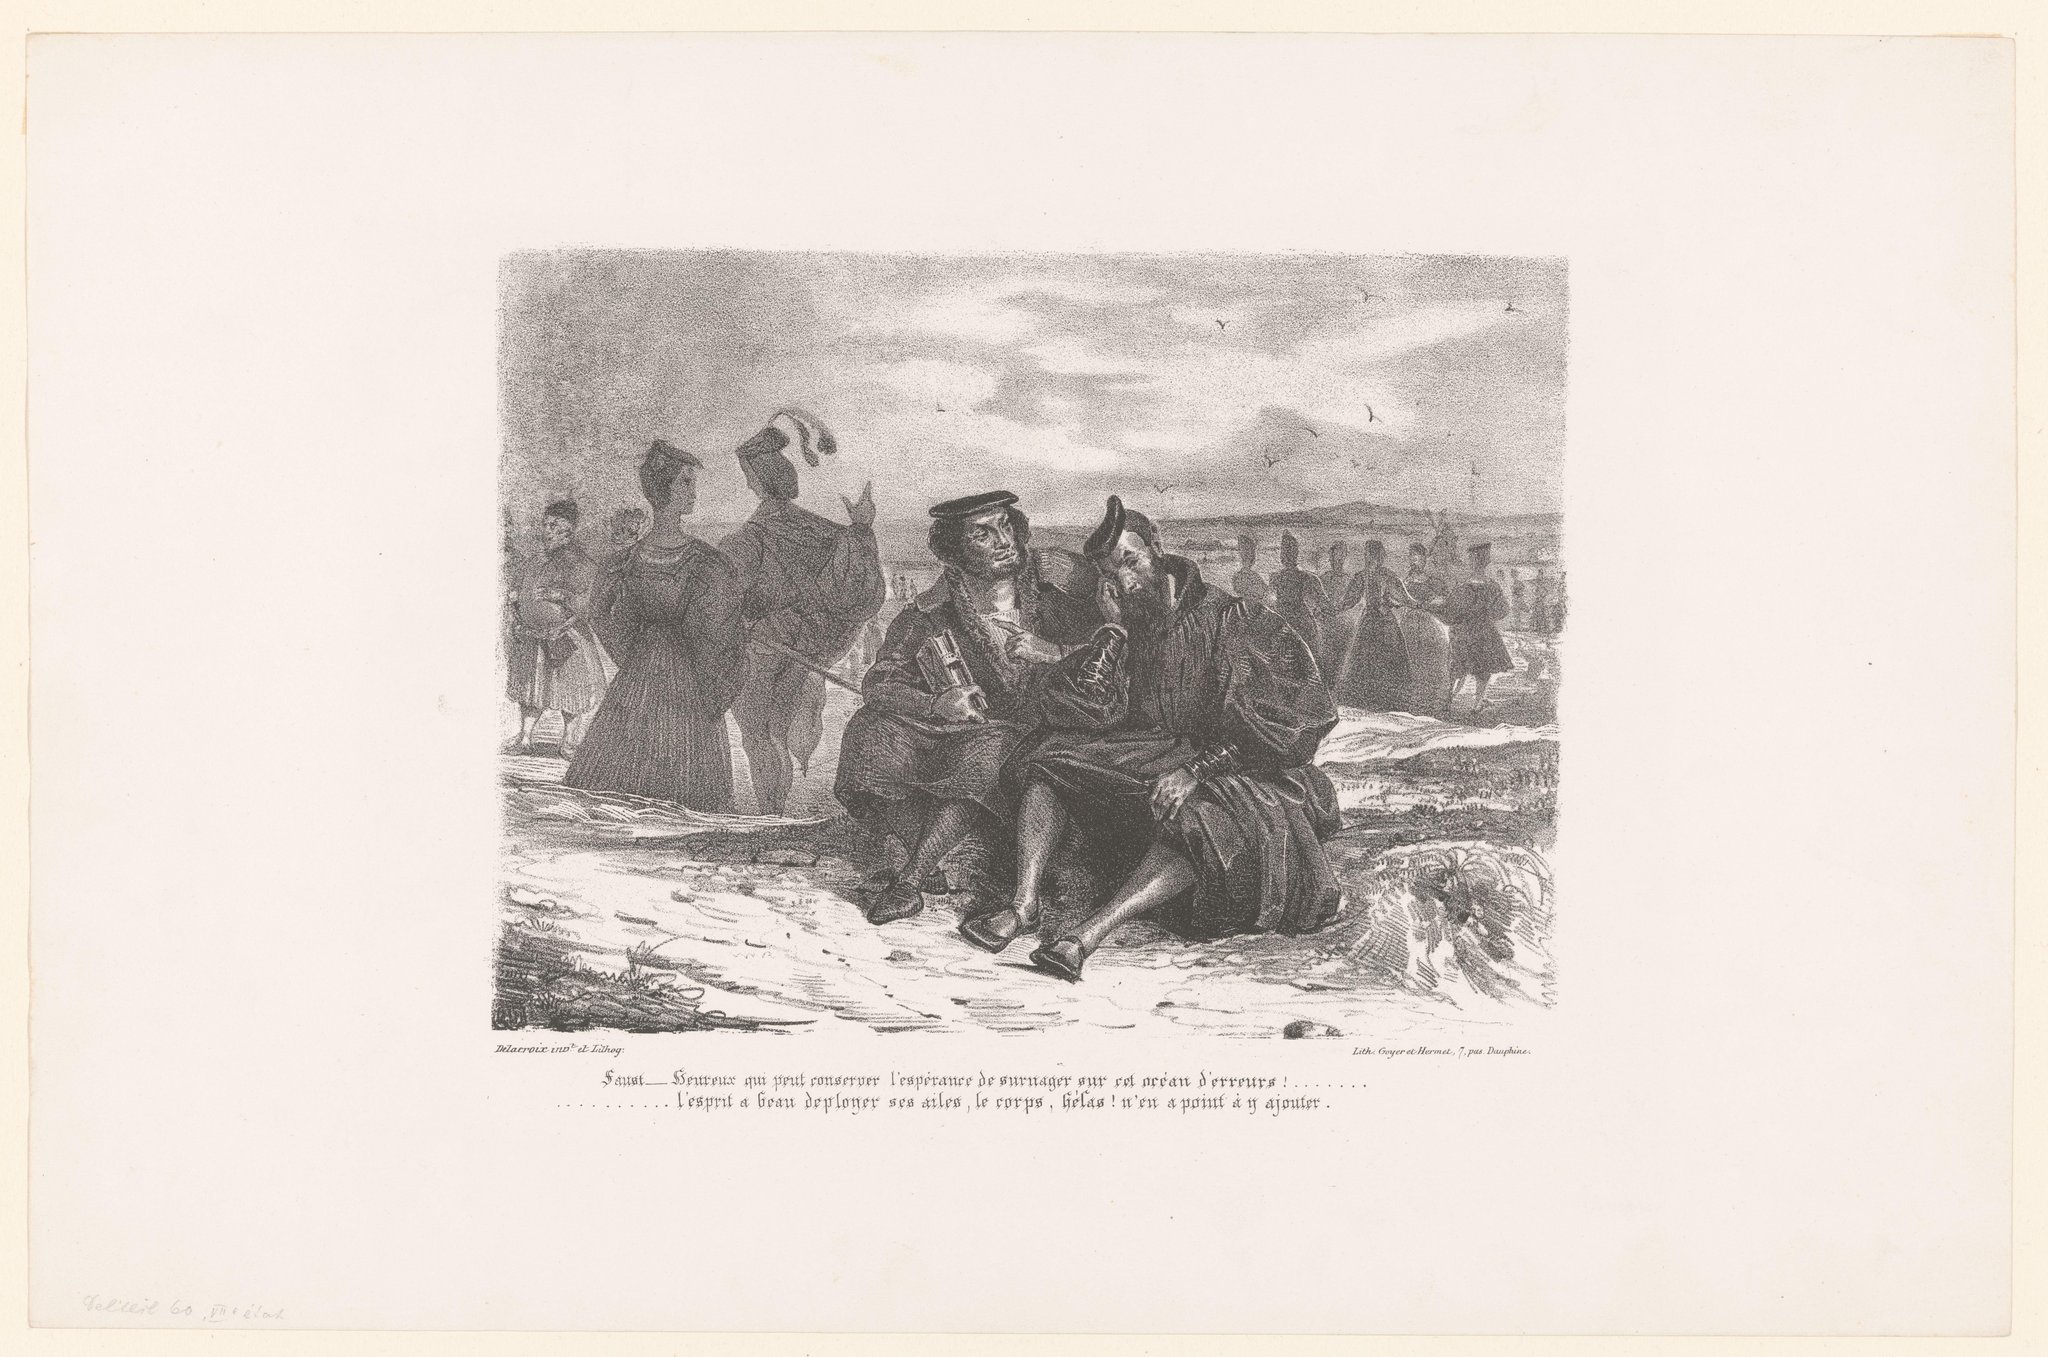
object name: print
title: Faust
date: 1828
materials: paper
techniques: lithograph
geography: paris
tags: (scenes from) specific works of literature: goethe, faust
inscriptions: collector's mark: Lugt 964, collector's mark: Lugt 2228a